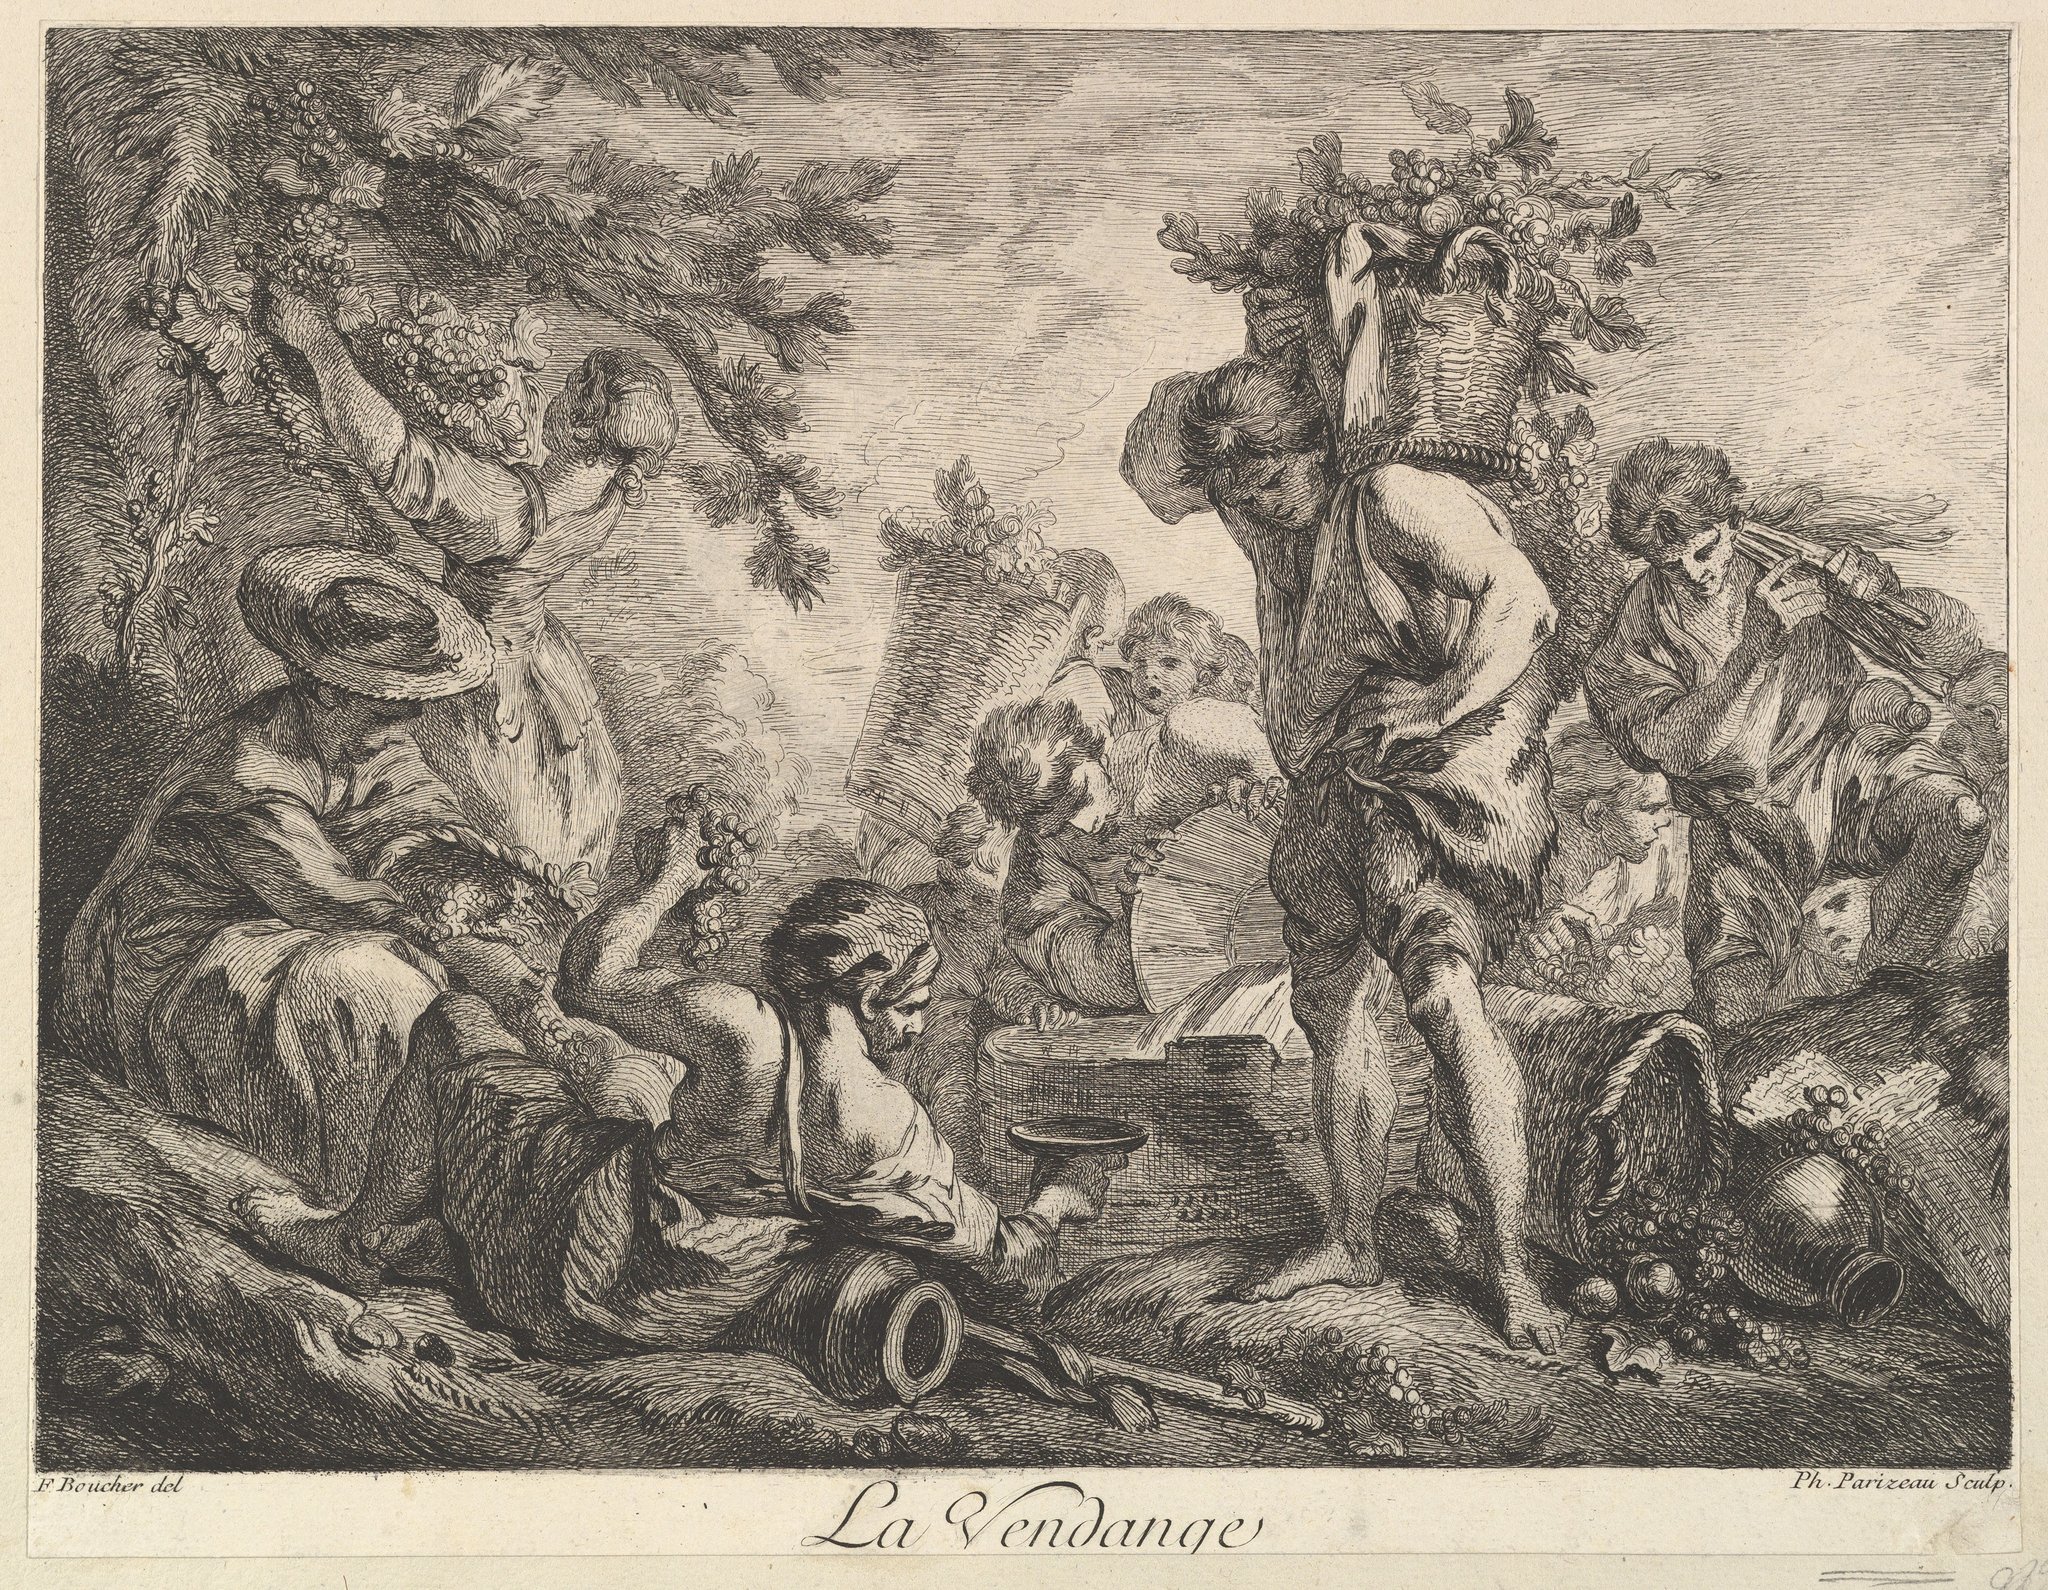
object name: print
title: The Grape Harvest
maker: philippe louis parizeau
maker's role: artist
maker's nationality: french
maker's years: 1740-1801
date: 1740-1801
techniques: drypoint, etching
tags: grapes,men,working